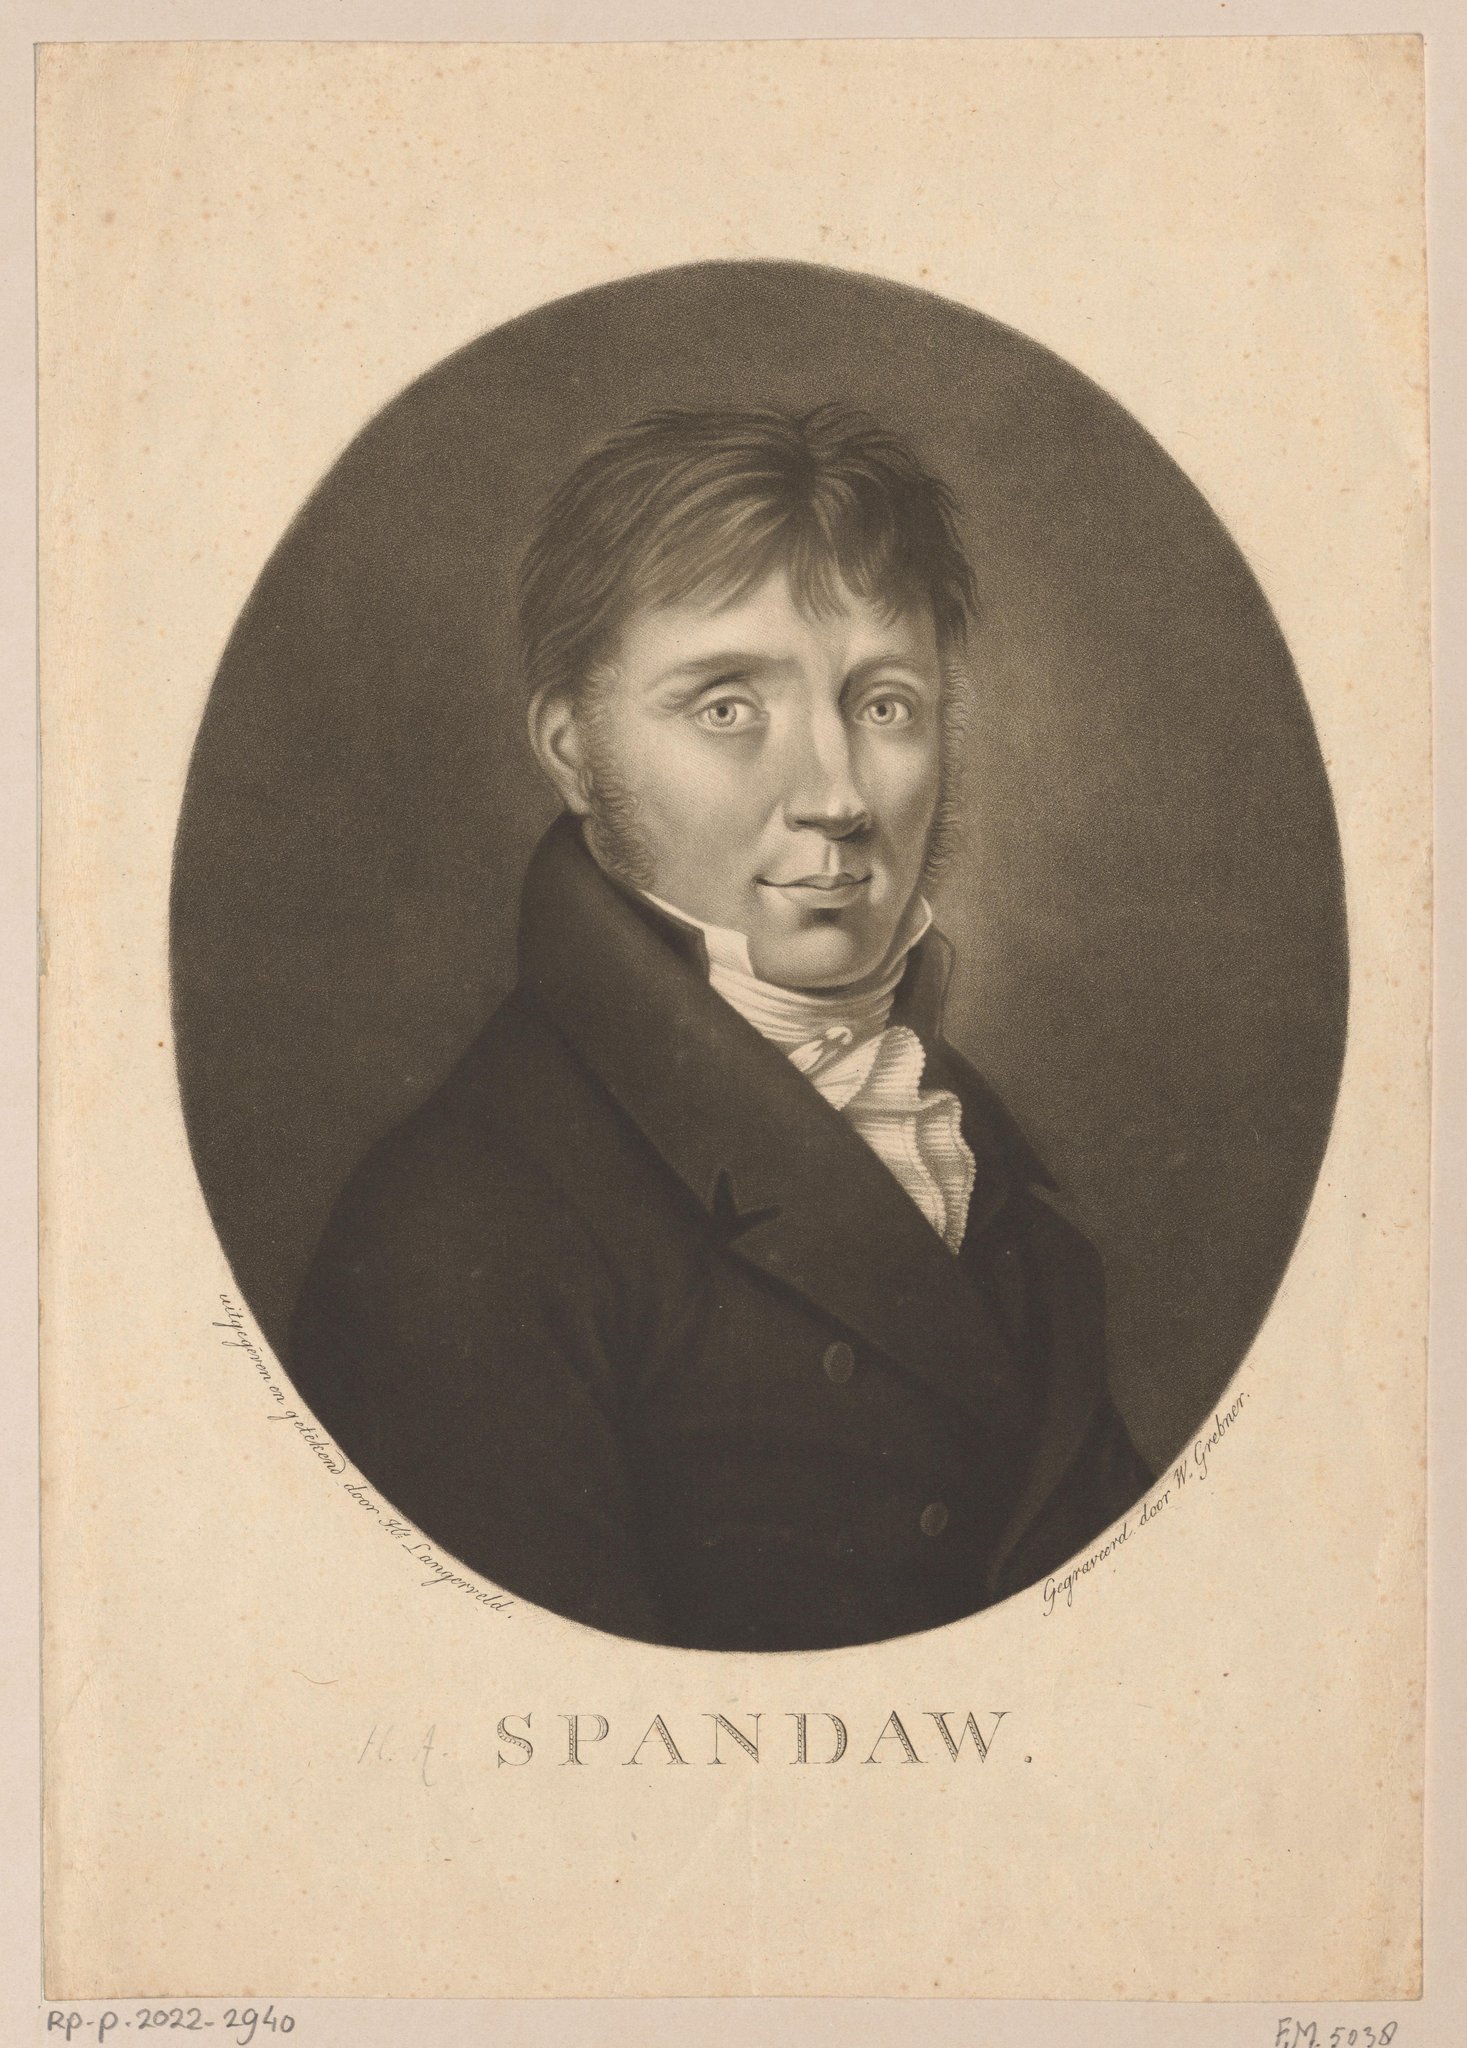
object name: print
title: Portret van Hajo Albert Spandaw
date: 1797-1830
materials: paper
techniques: mezzotint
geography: amsterdam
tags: hajo albert spandaw, historical persons, portrait of a writer